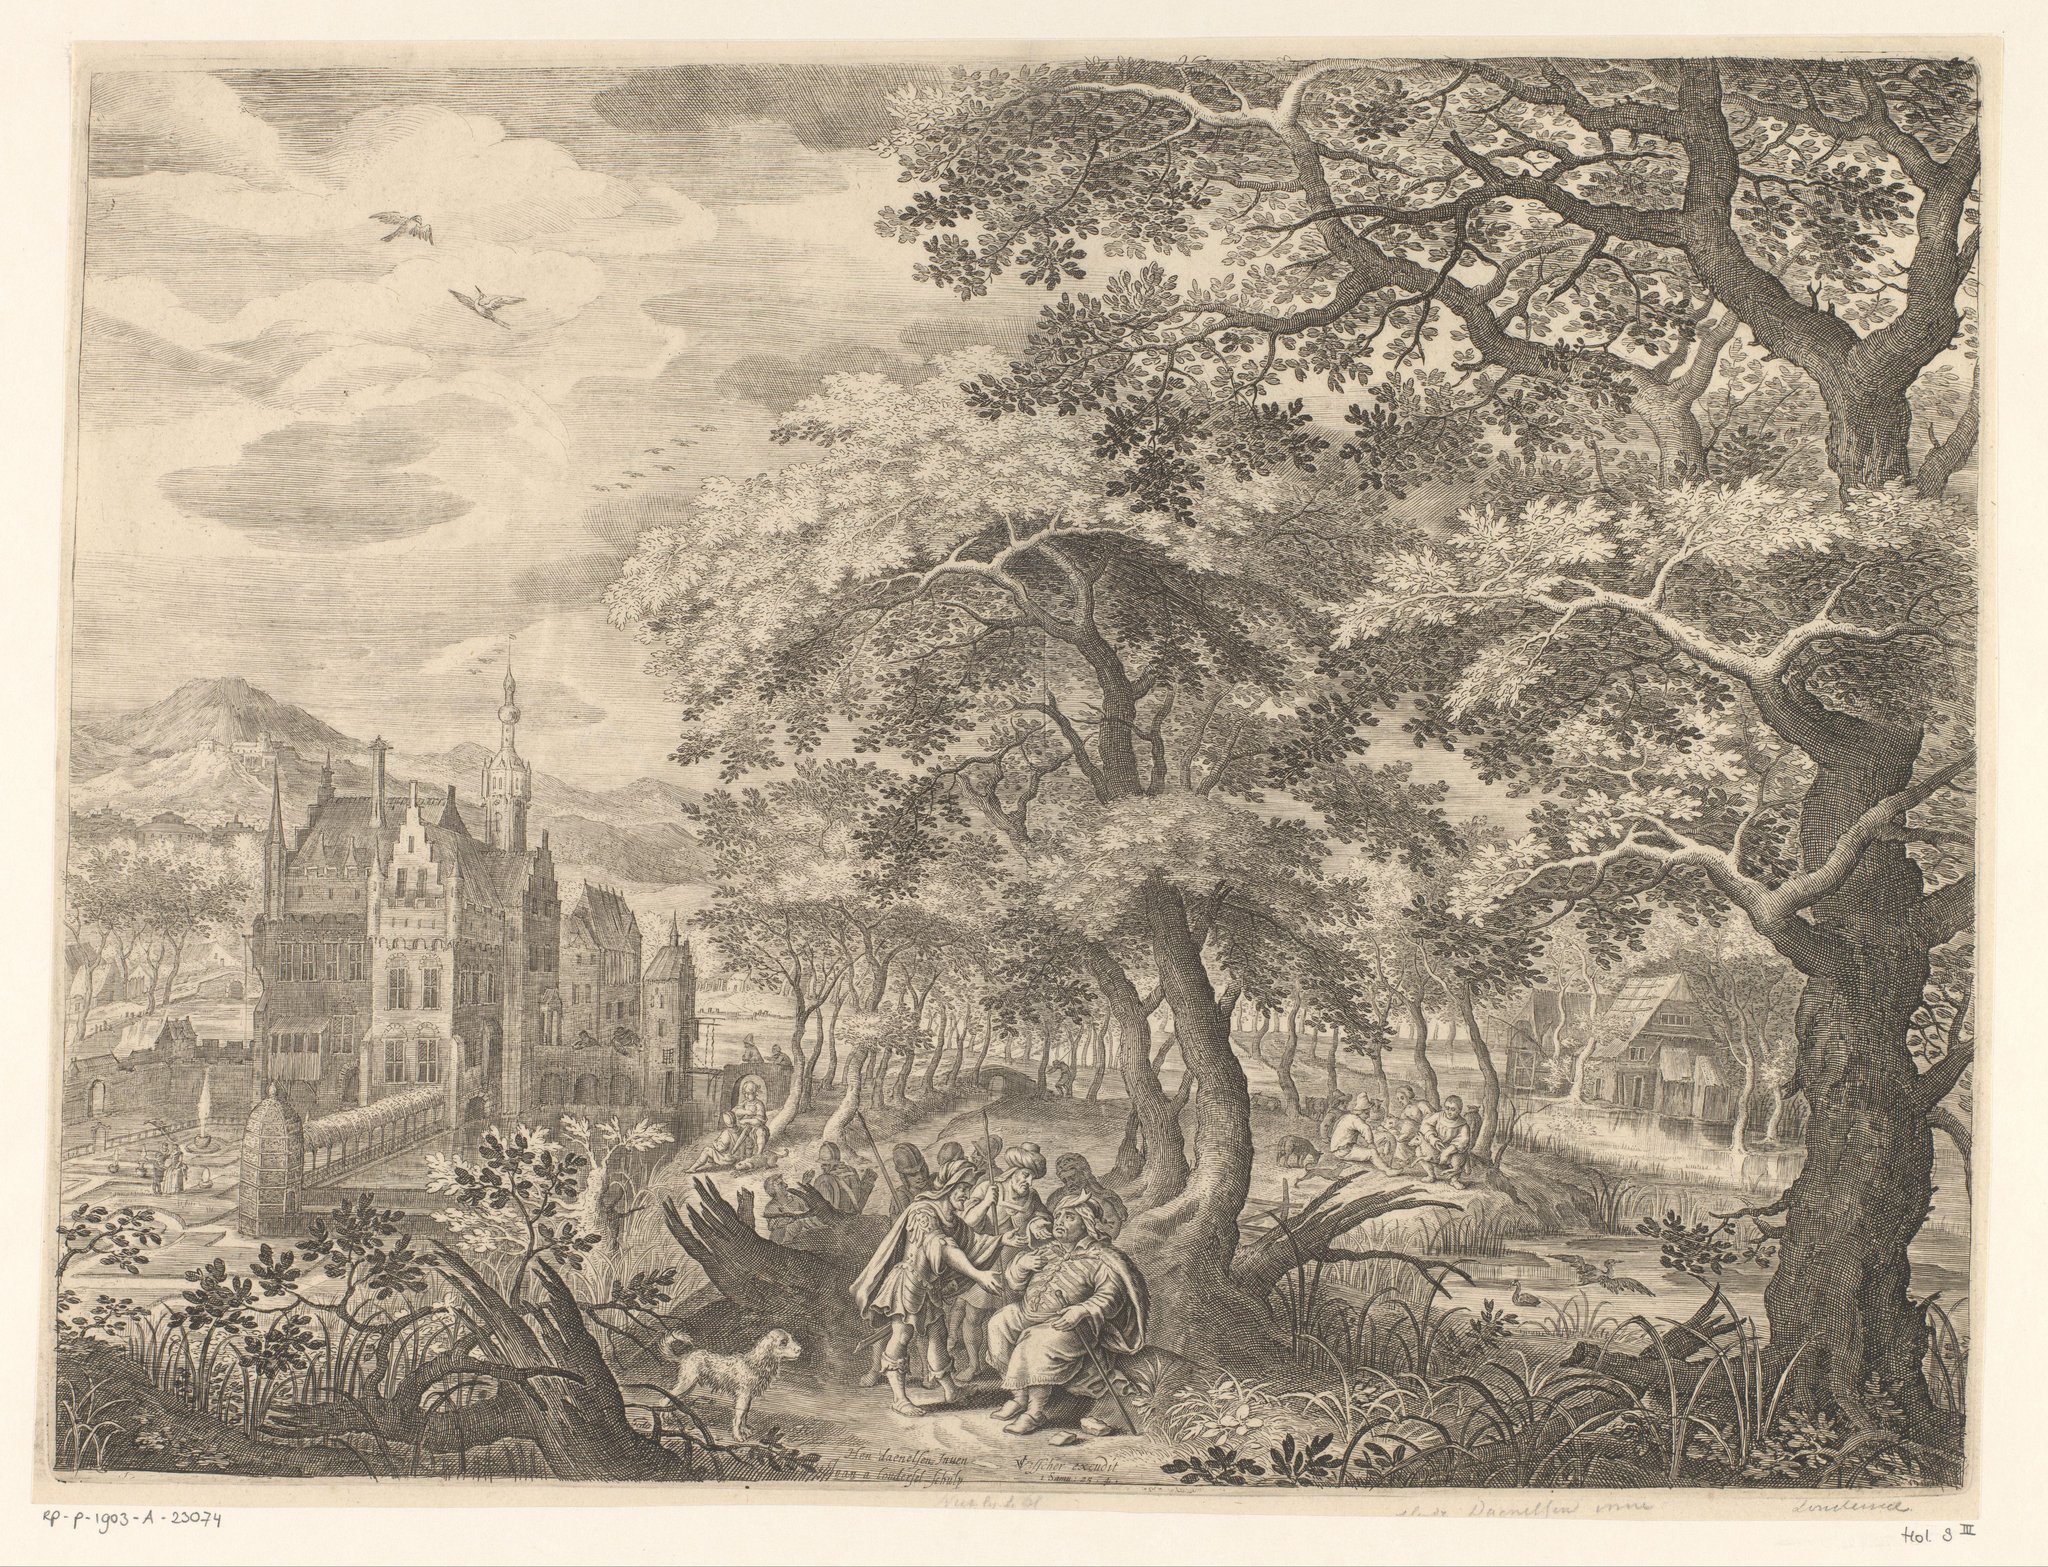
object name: print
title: Landschap met Davids mannen die Nabal om voedsel vragen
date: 1601-1652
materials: paper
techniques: engraving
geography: amsterdam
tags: david spares nabal's sheep, landscape with tower or castle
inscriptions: collector's mark: Lugt 2228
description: Davids knechten komen bij Nabal, die onder een boom zit, en vragen hem om voedsel. Nabal weigert de mannen en David eten te geven. Op de achtergrond scheren de knechten van Nabal zijn schapen. Links in het landschap een kasteel. Bijbelverwijzing middenonder: 1 Sam. 25:4.